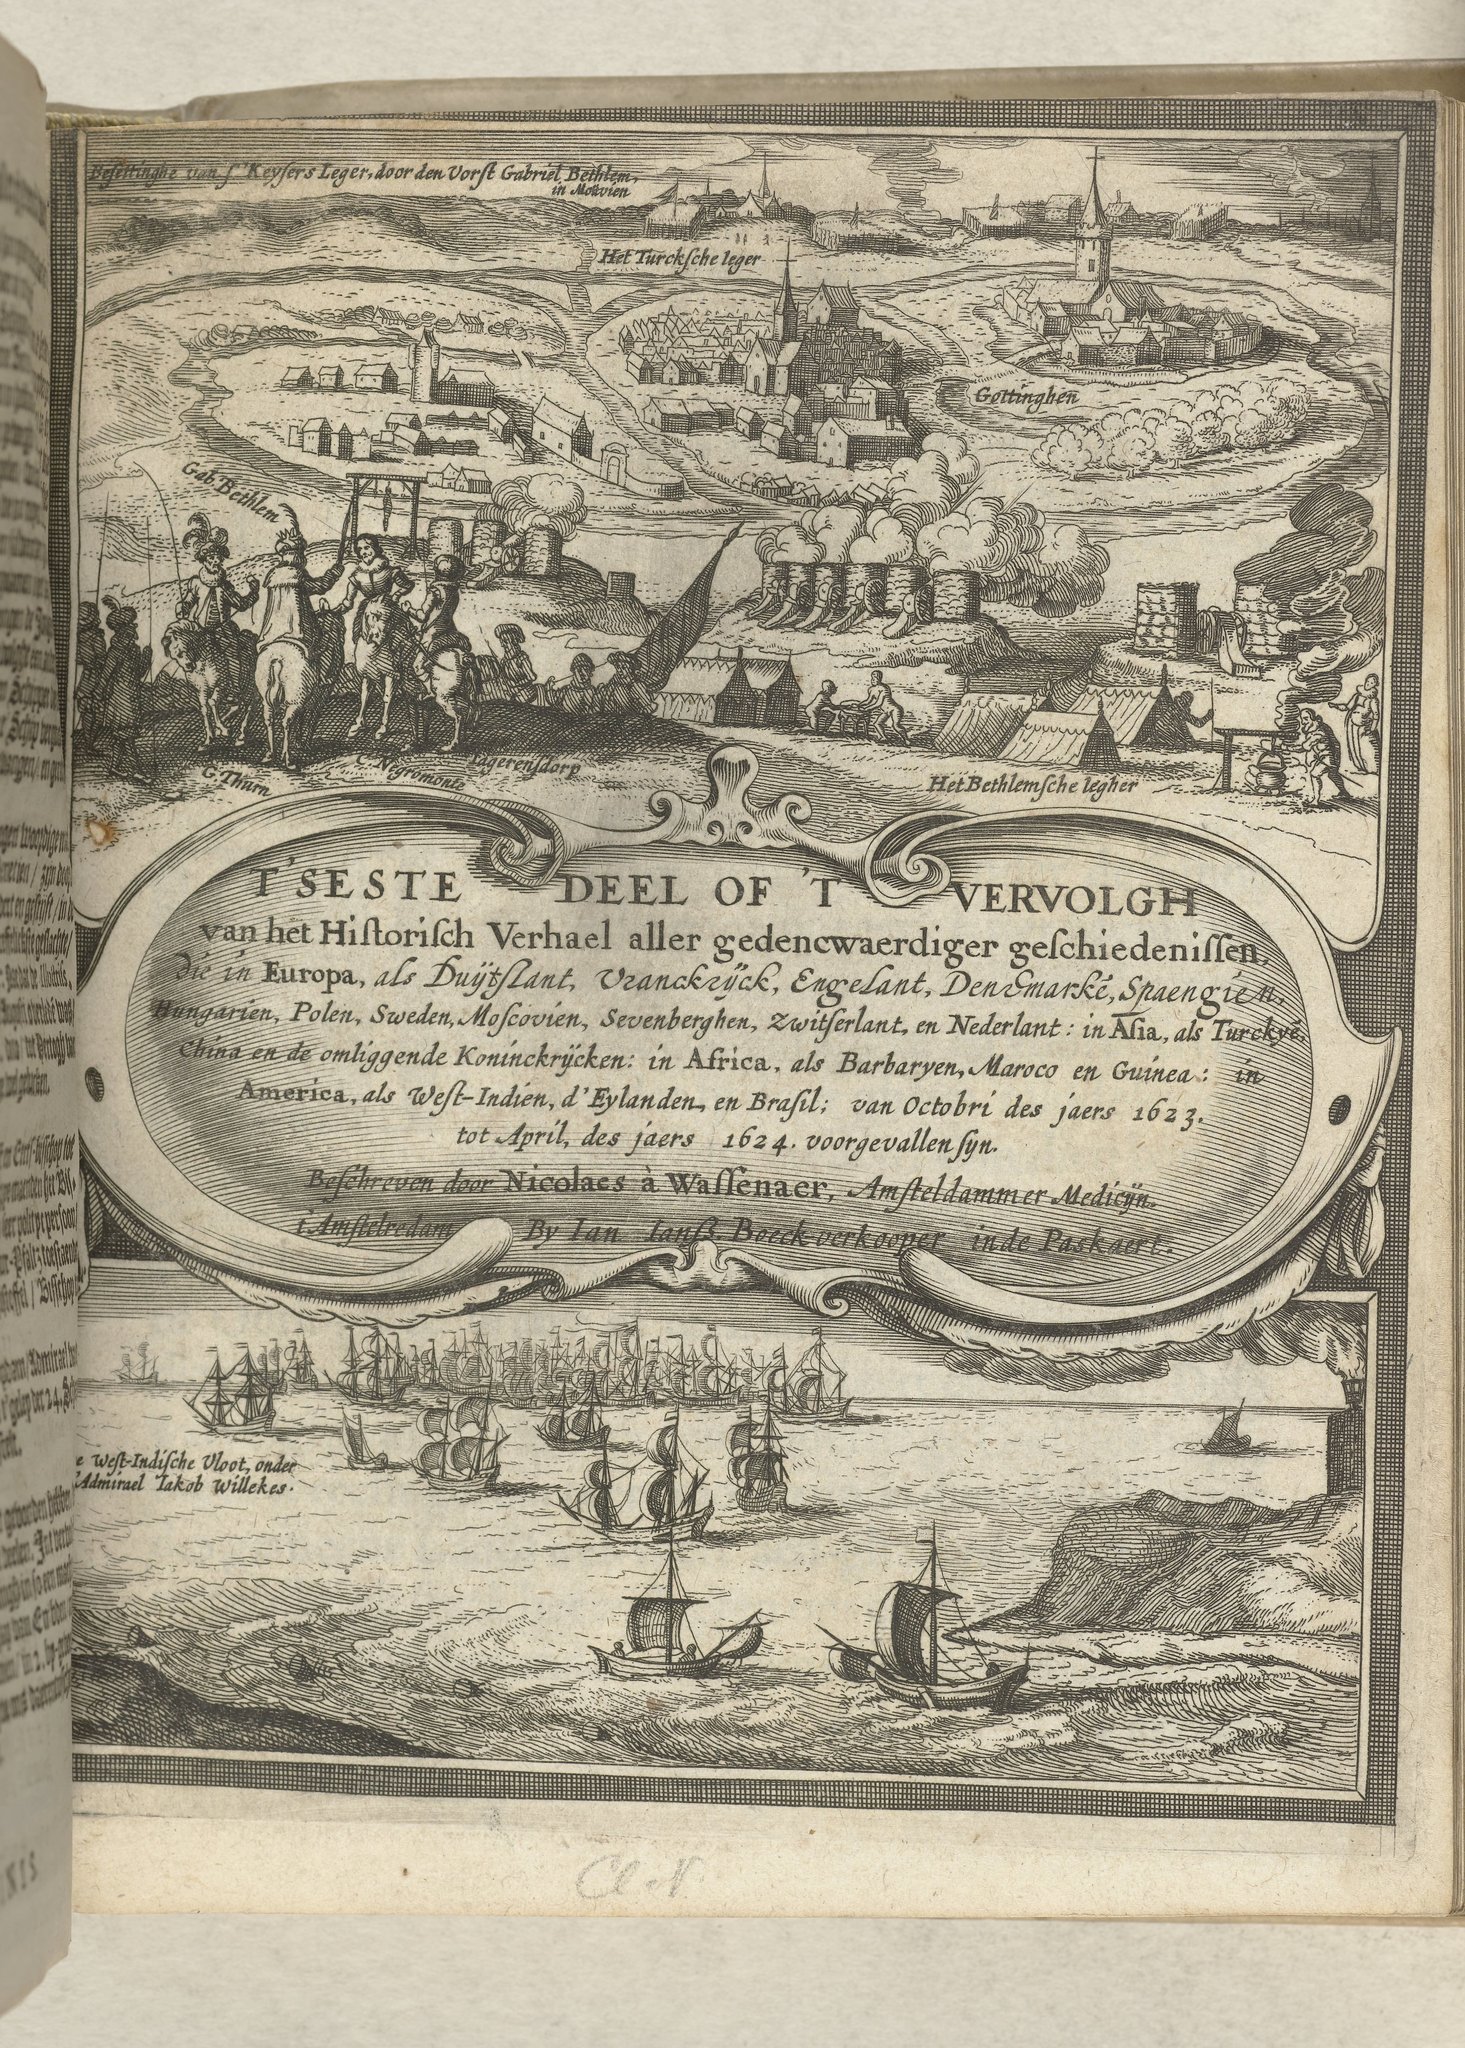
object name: print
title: Titelblad van Historisch verhael, band 2 (dl. 6), 1624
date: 1623-1624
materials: paper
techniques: etching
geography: amsterdam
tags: siege, position war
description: Titelblad van Historisch verhael, band 2 (dl. 6), 1624. Titelblad met twee voorstellingen. Boven gevechten tussen de Hongaren onder Gabriel Bethlen en de keizerlijke troepen bij Göttingen. Onder de West-Indische vloot onder admiraal Jacob Willekens. In het midden een cartouche met de titel.